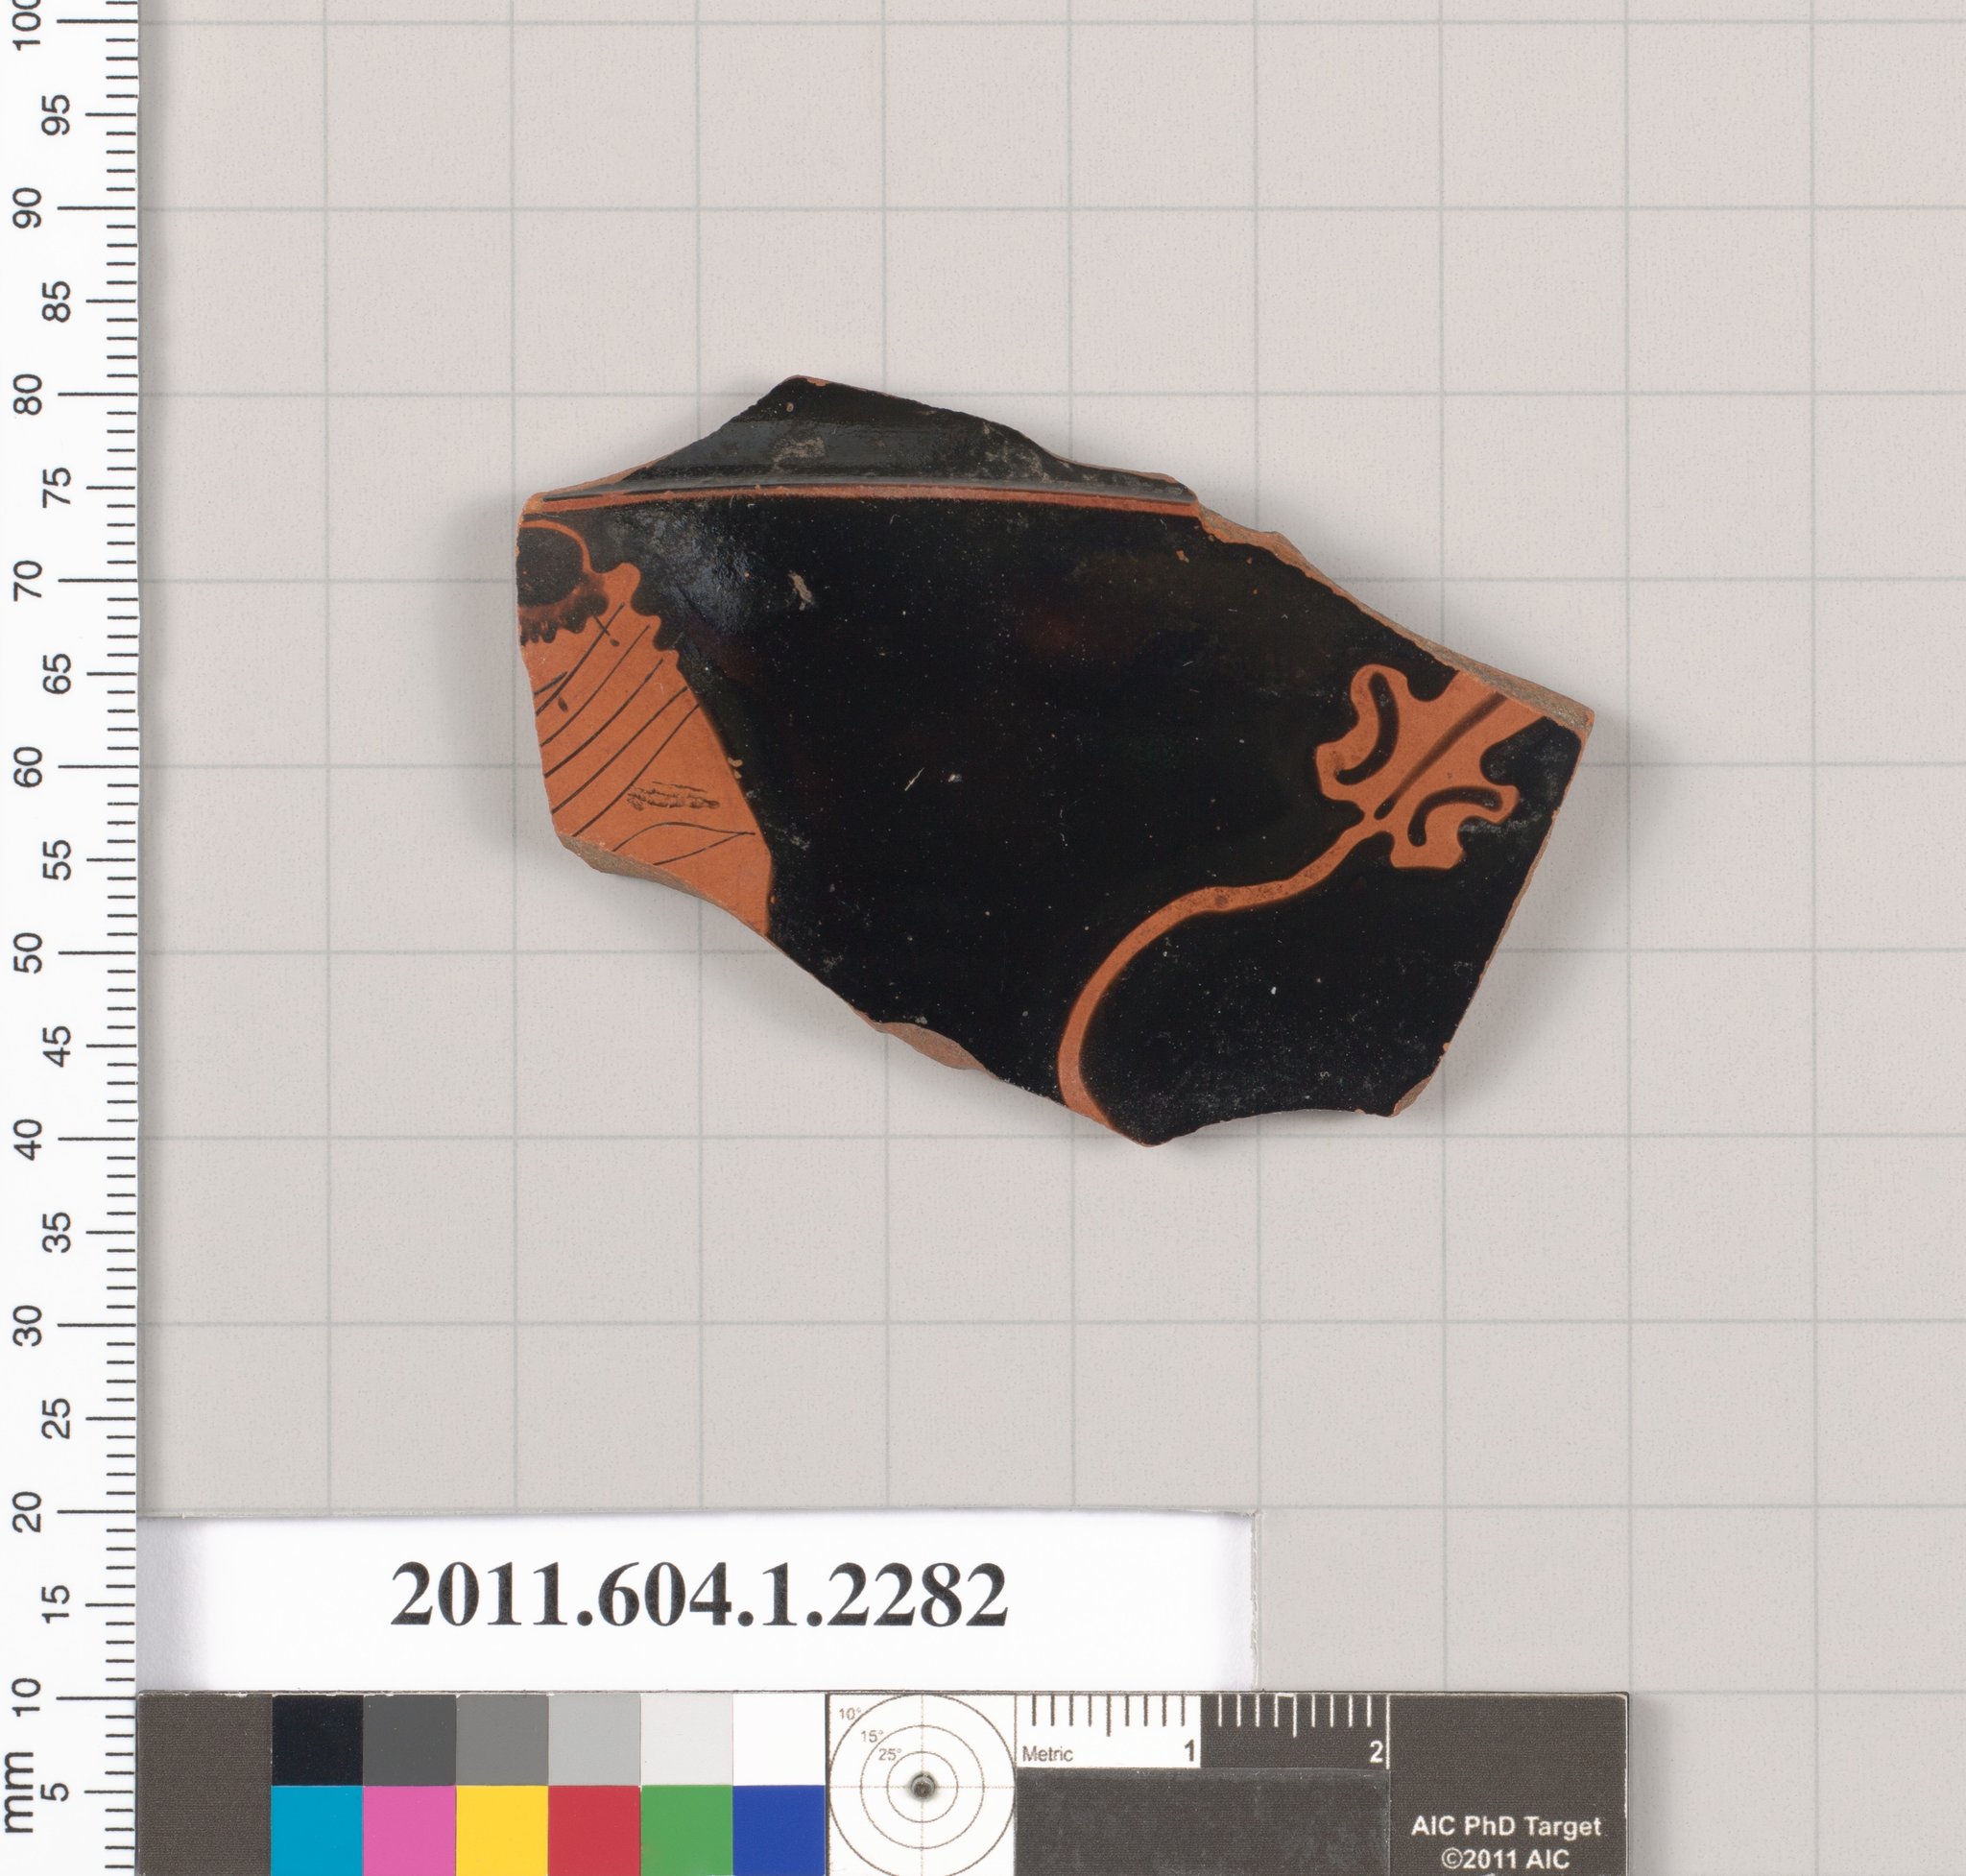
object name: kylix fragment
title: Terracotta fragment of a kylix (drinking cup)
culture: greek, attic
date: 475-451 BCE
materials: terracotta